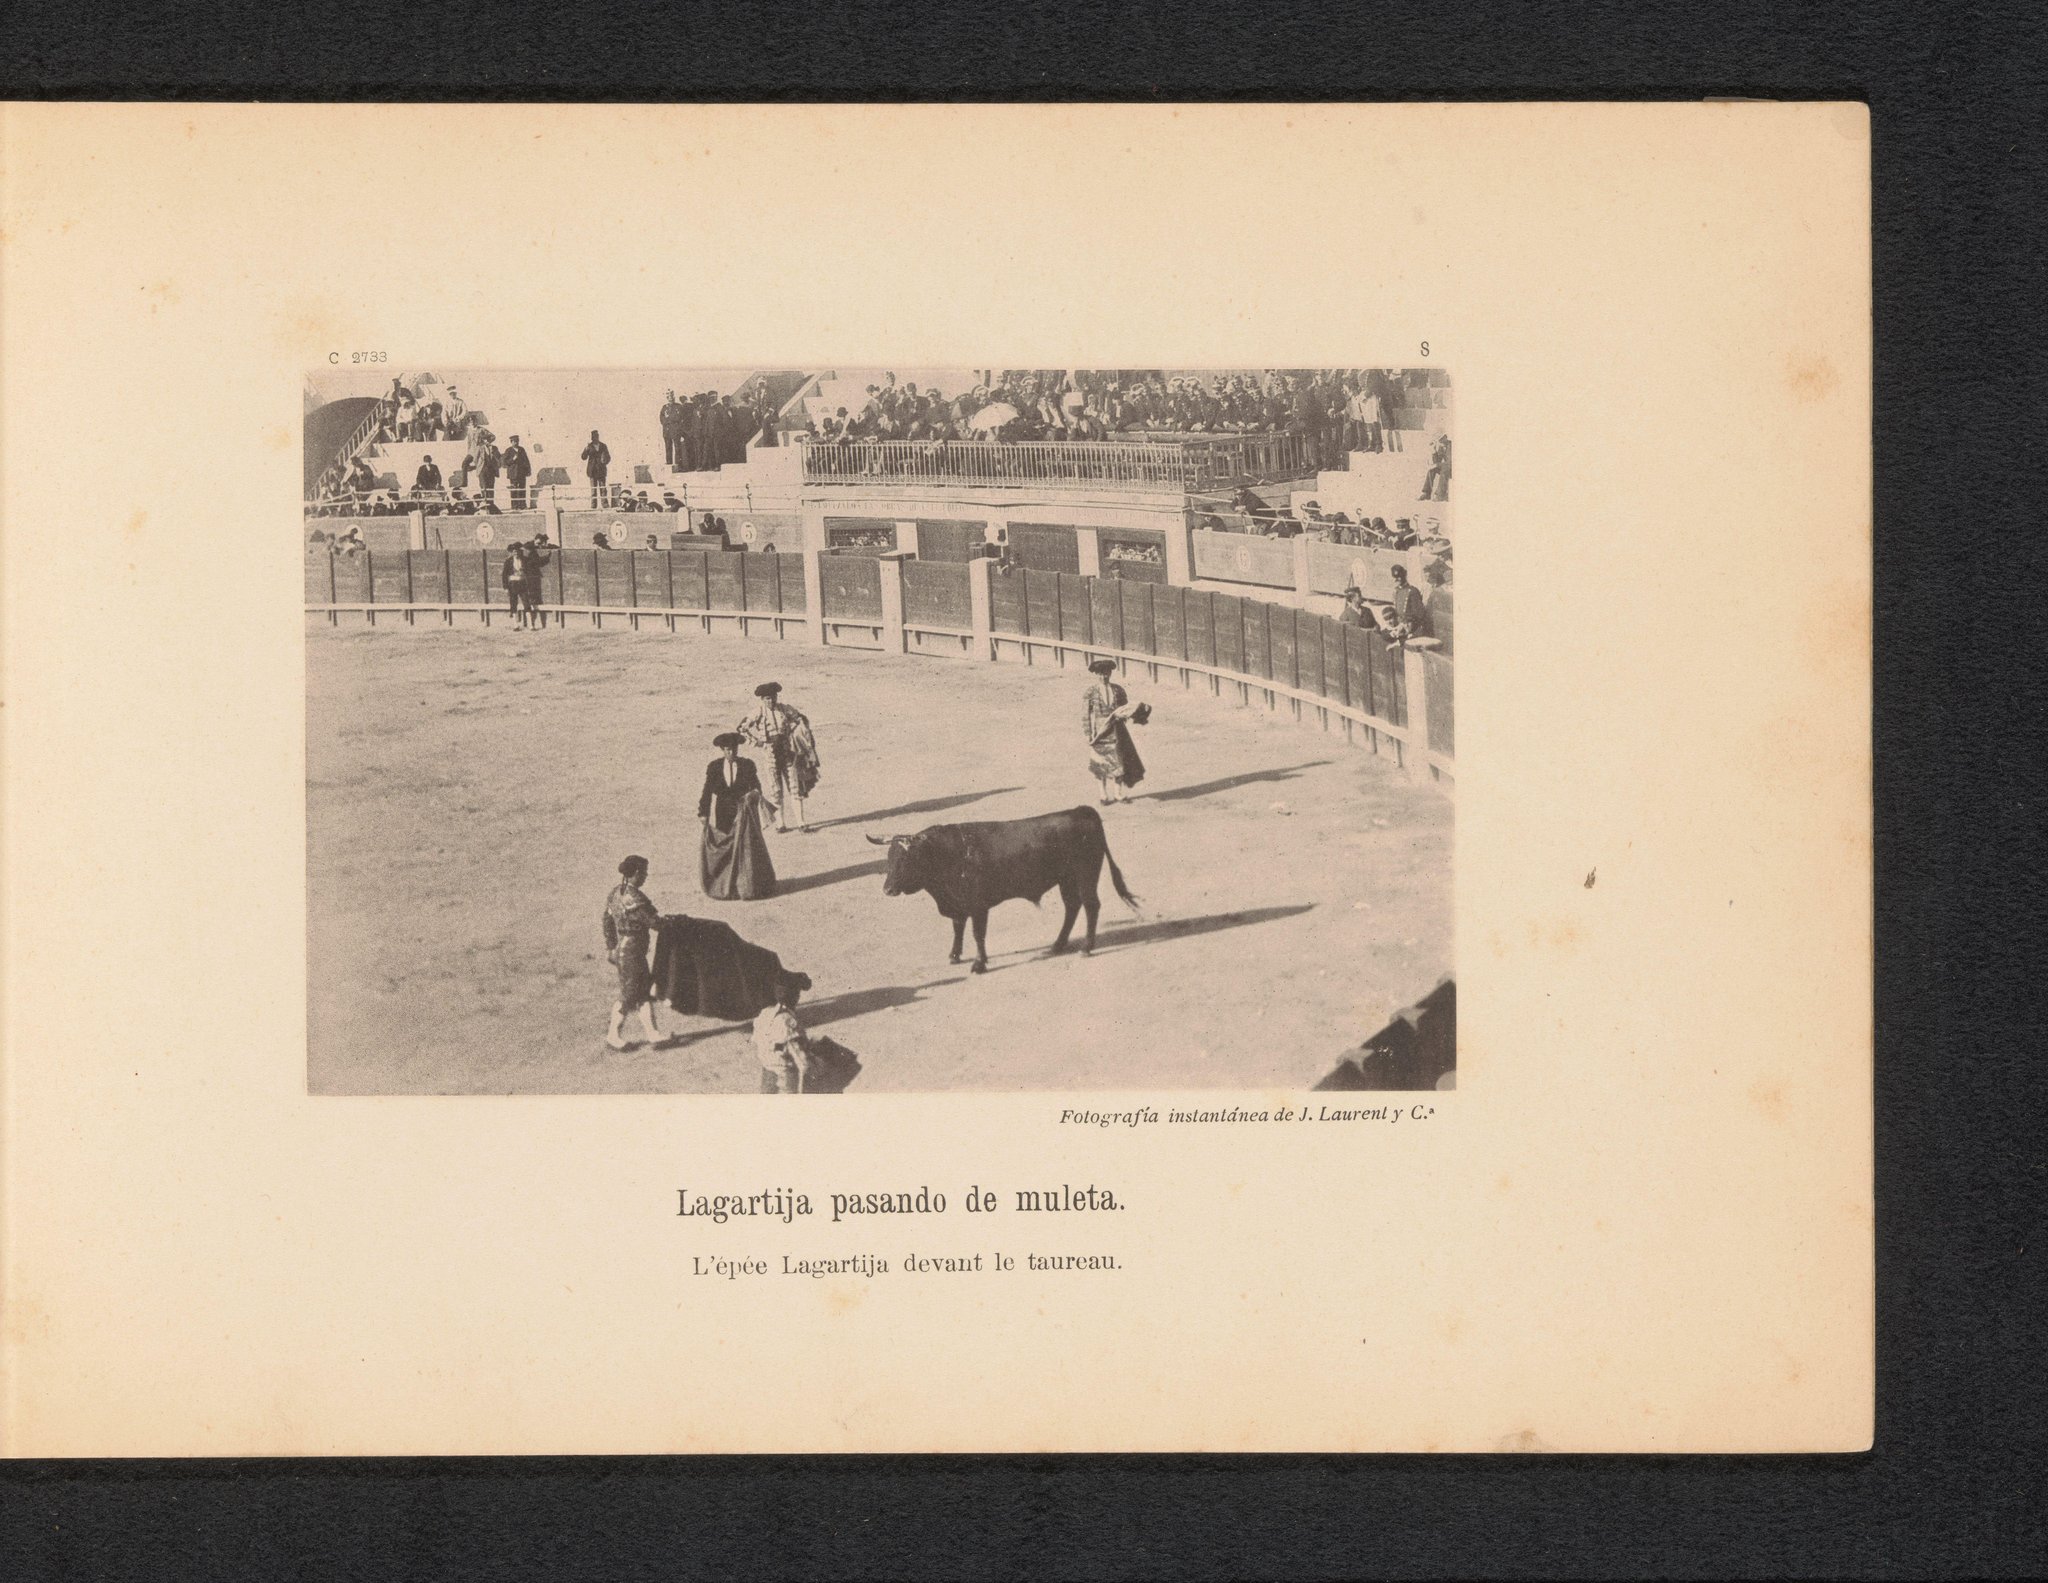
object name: photomechanical print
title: Lagartija pasando de muleta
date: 1880-1890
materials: paper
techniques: photograph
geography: madrid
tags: bullfight, bull-fighter, toreador, theatre (building) - aa - open-air performances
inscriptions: number: ‘8’, number: ‘C. 2733’